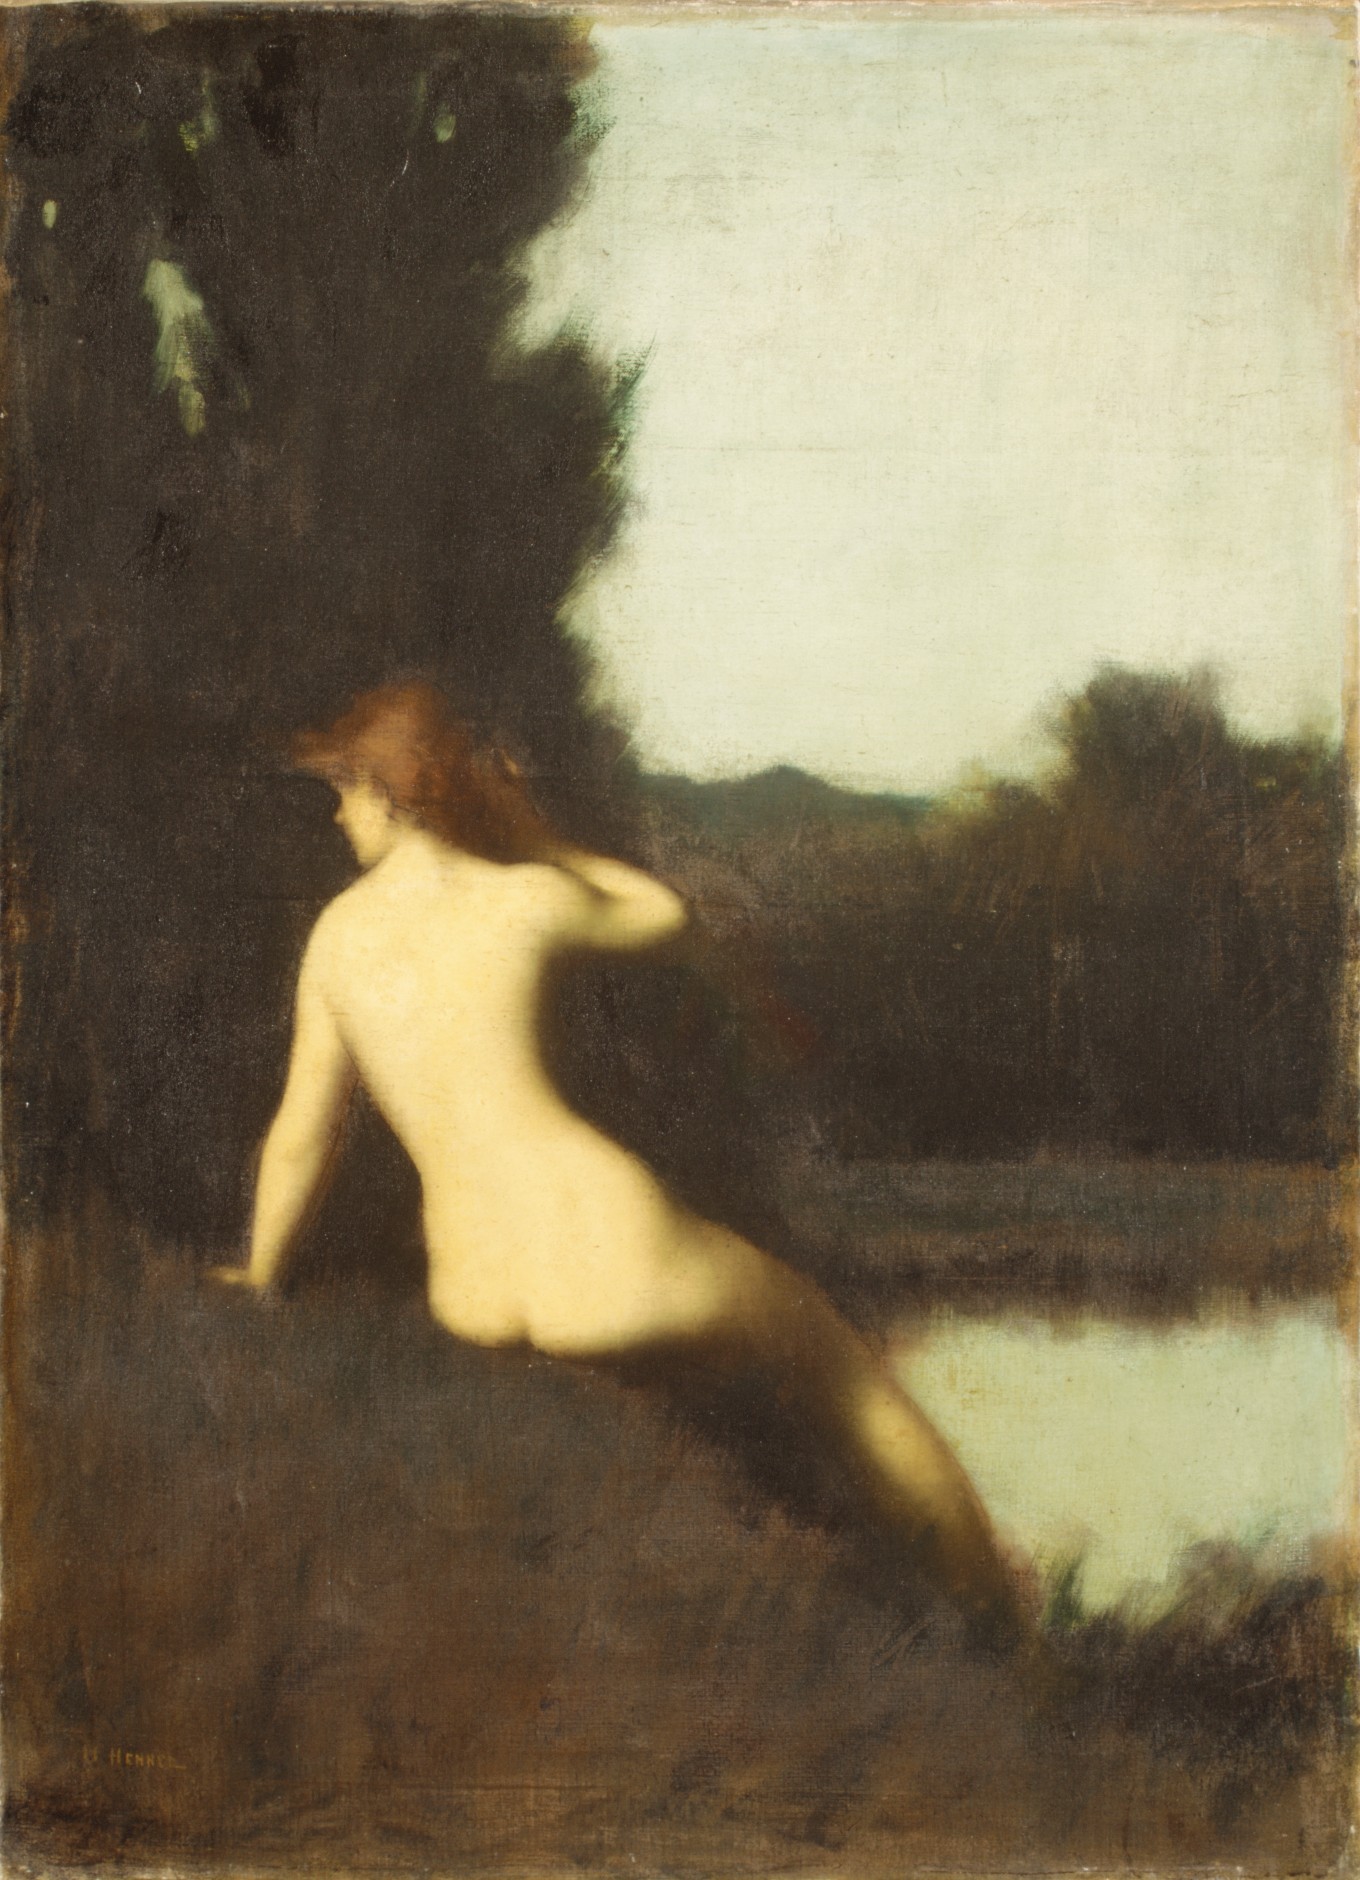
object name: painting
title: A Bather (Echo)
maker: jean-jacques henner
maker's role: artist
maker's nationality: french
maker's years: 1829-1905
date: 1881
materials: canvas, oil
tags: female nudes